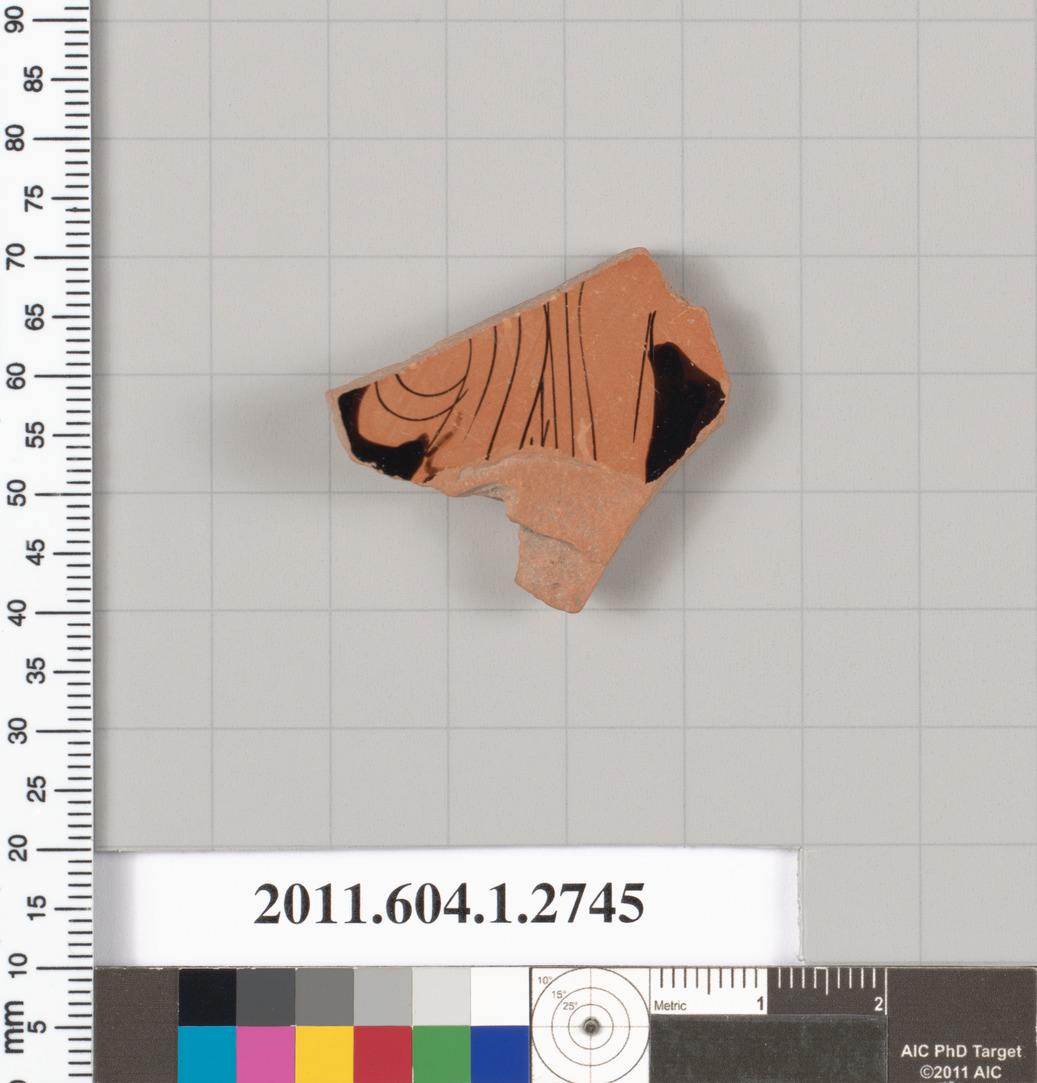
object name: kylix fragment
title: Terracotta fragment of a kylix (drinking cup)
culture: greek, attic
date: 470-460 BCE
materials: terracotta